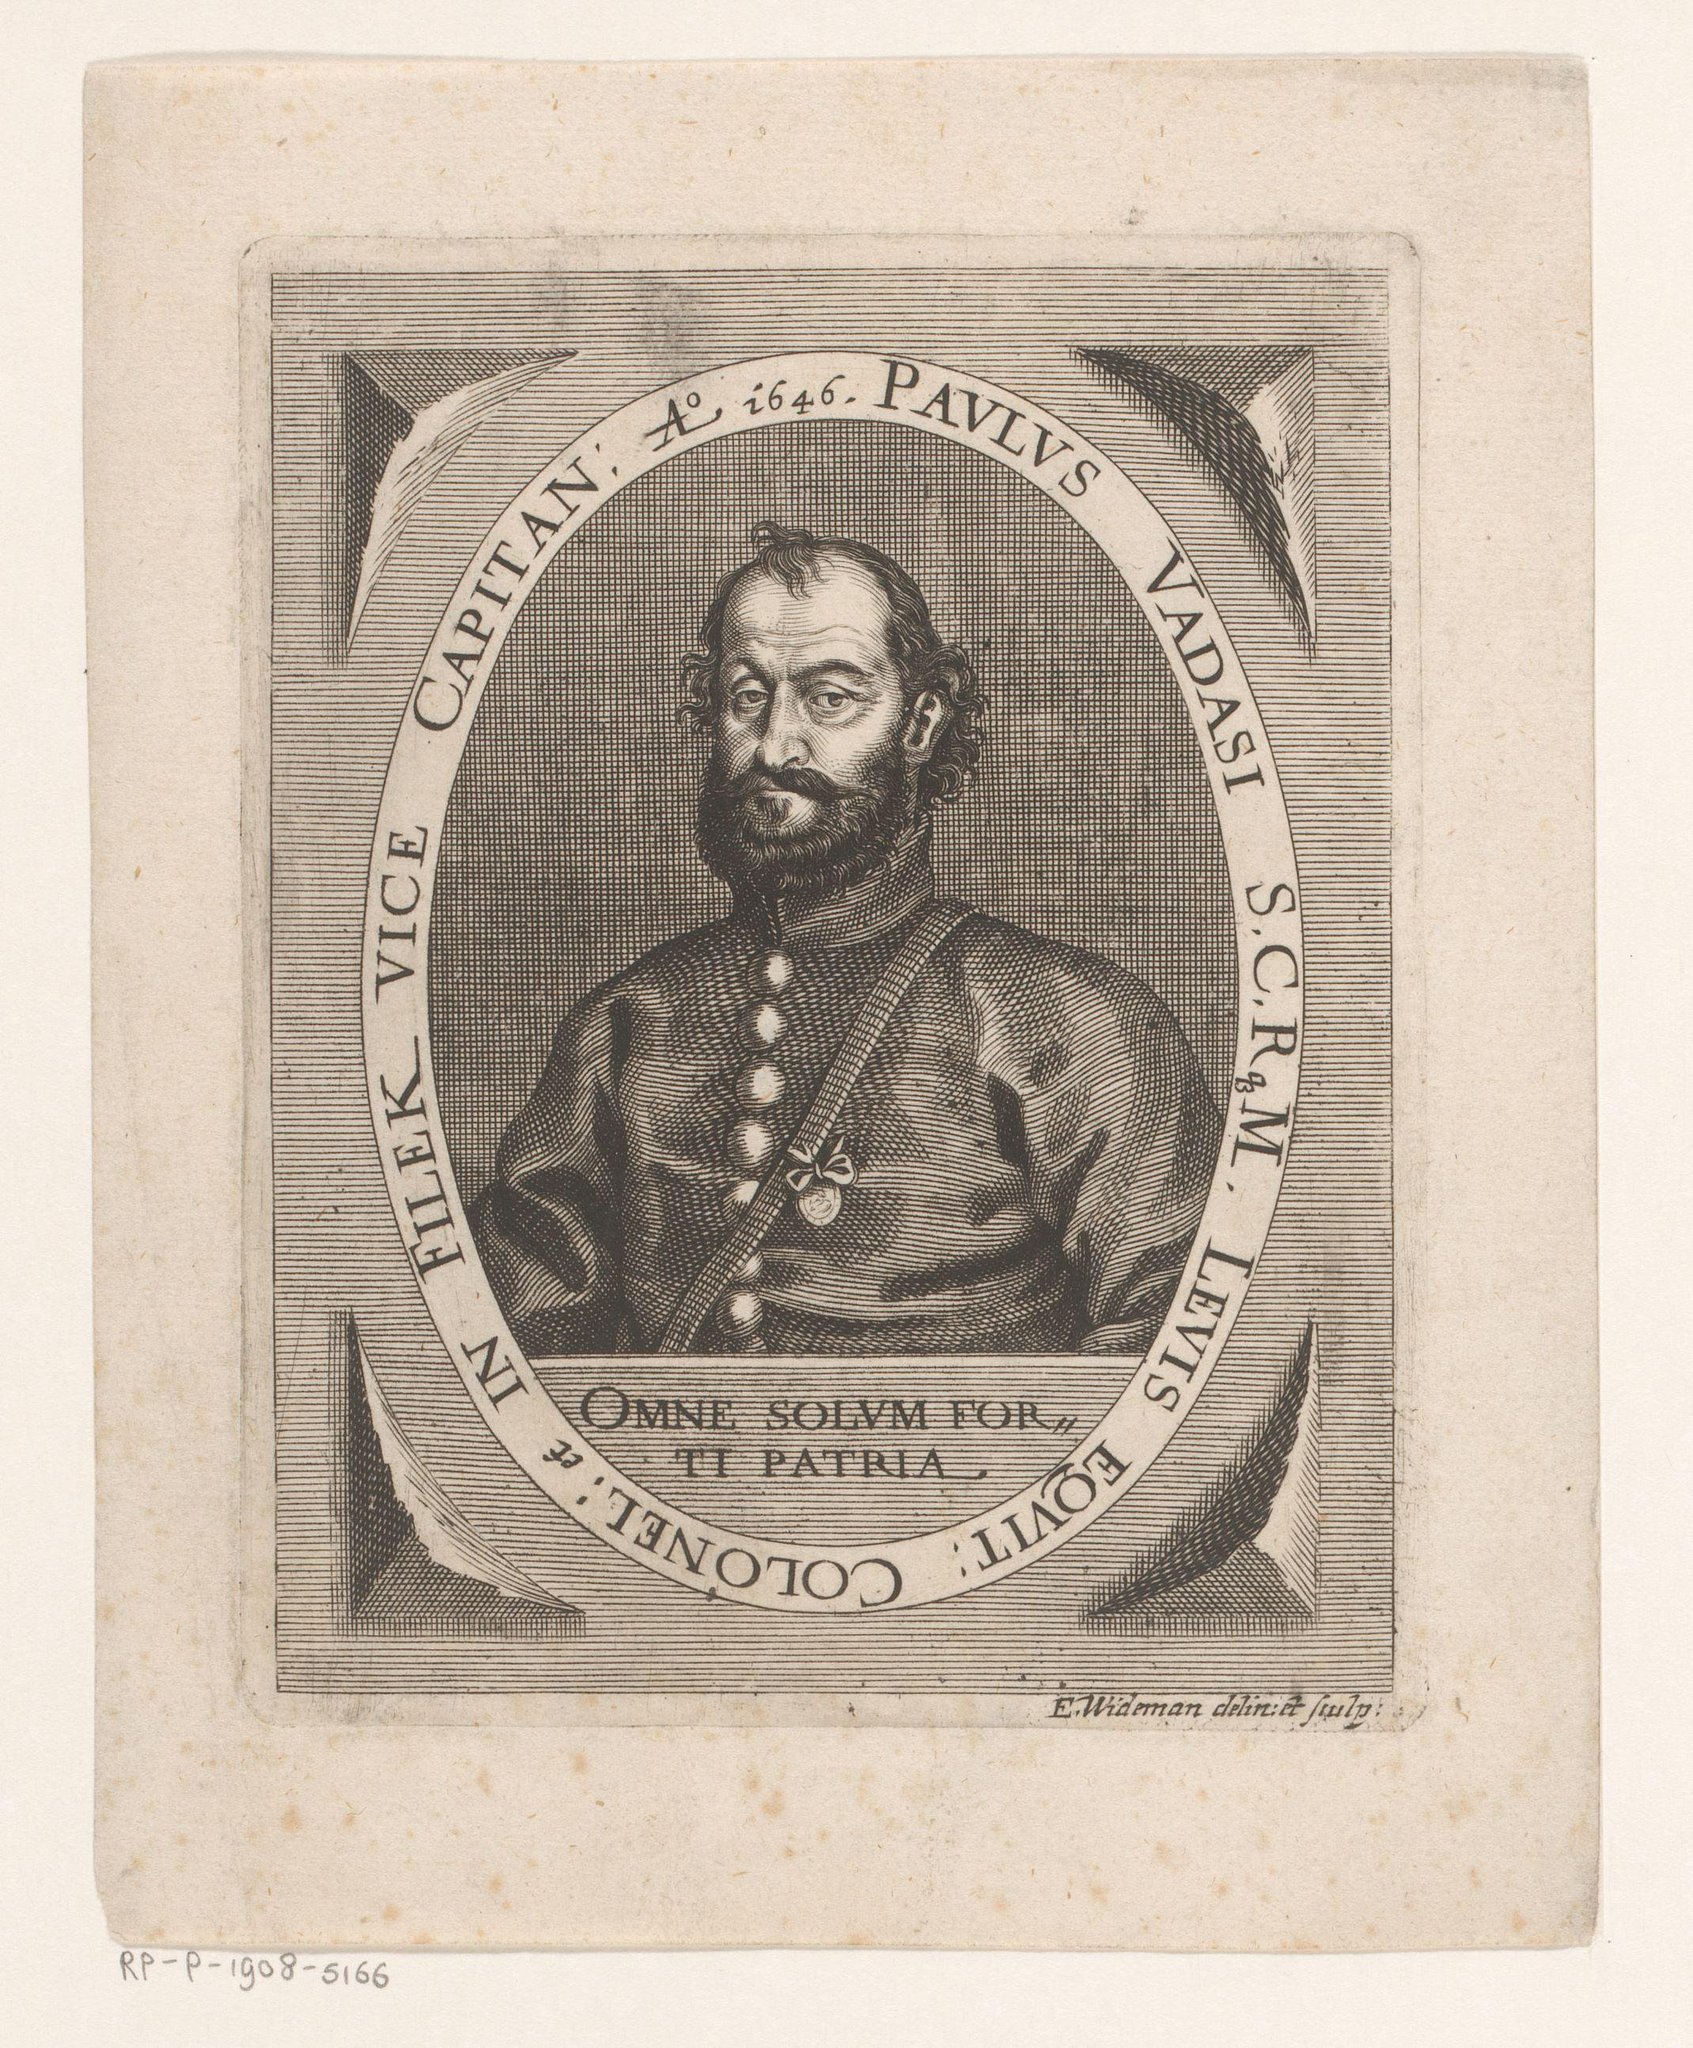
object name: print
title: Portret van Pál Vadászi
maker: elias widemann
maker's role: print maker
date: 1646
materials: paper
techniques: engraving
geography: vienna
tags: historical persons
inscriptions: collector's mark: Lugt 2228